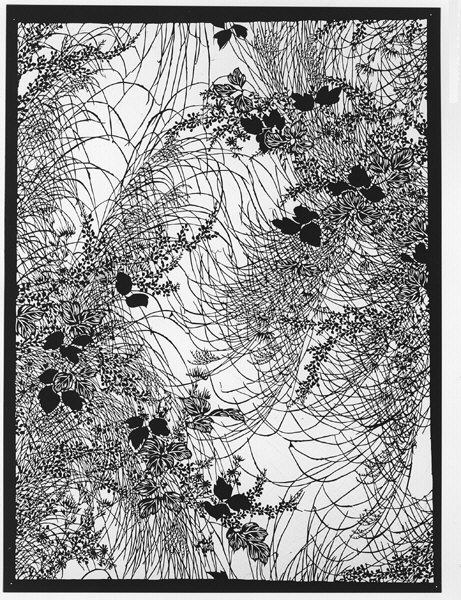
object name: stencil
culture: japanese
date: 1868-1912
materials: paper, silk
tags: plants